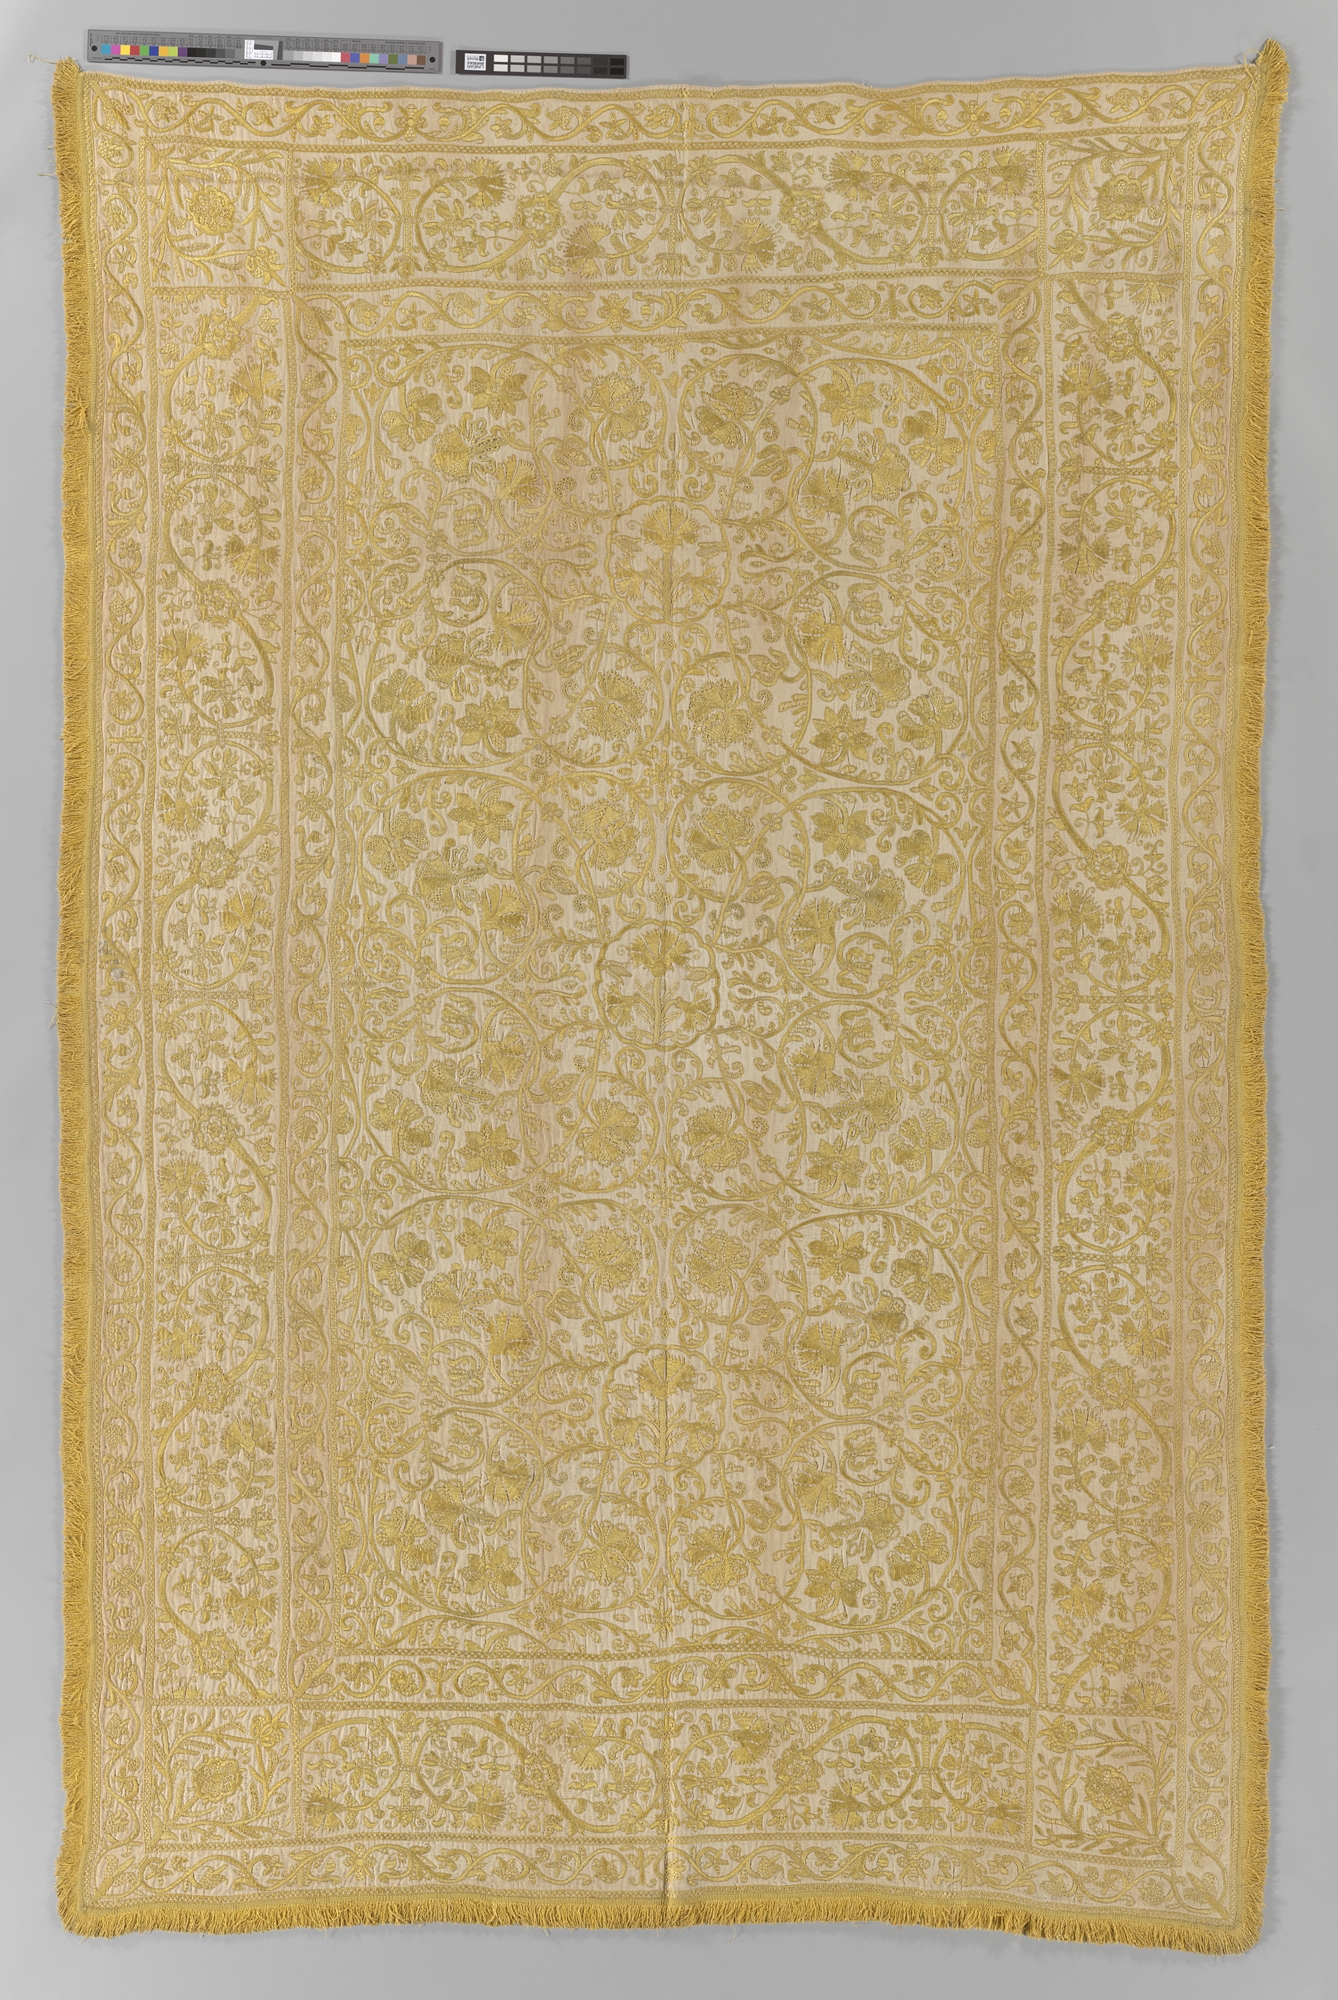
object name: table cover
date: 1567-1633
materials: linen, silk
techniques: embroidery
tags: birds,flowers